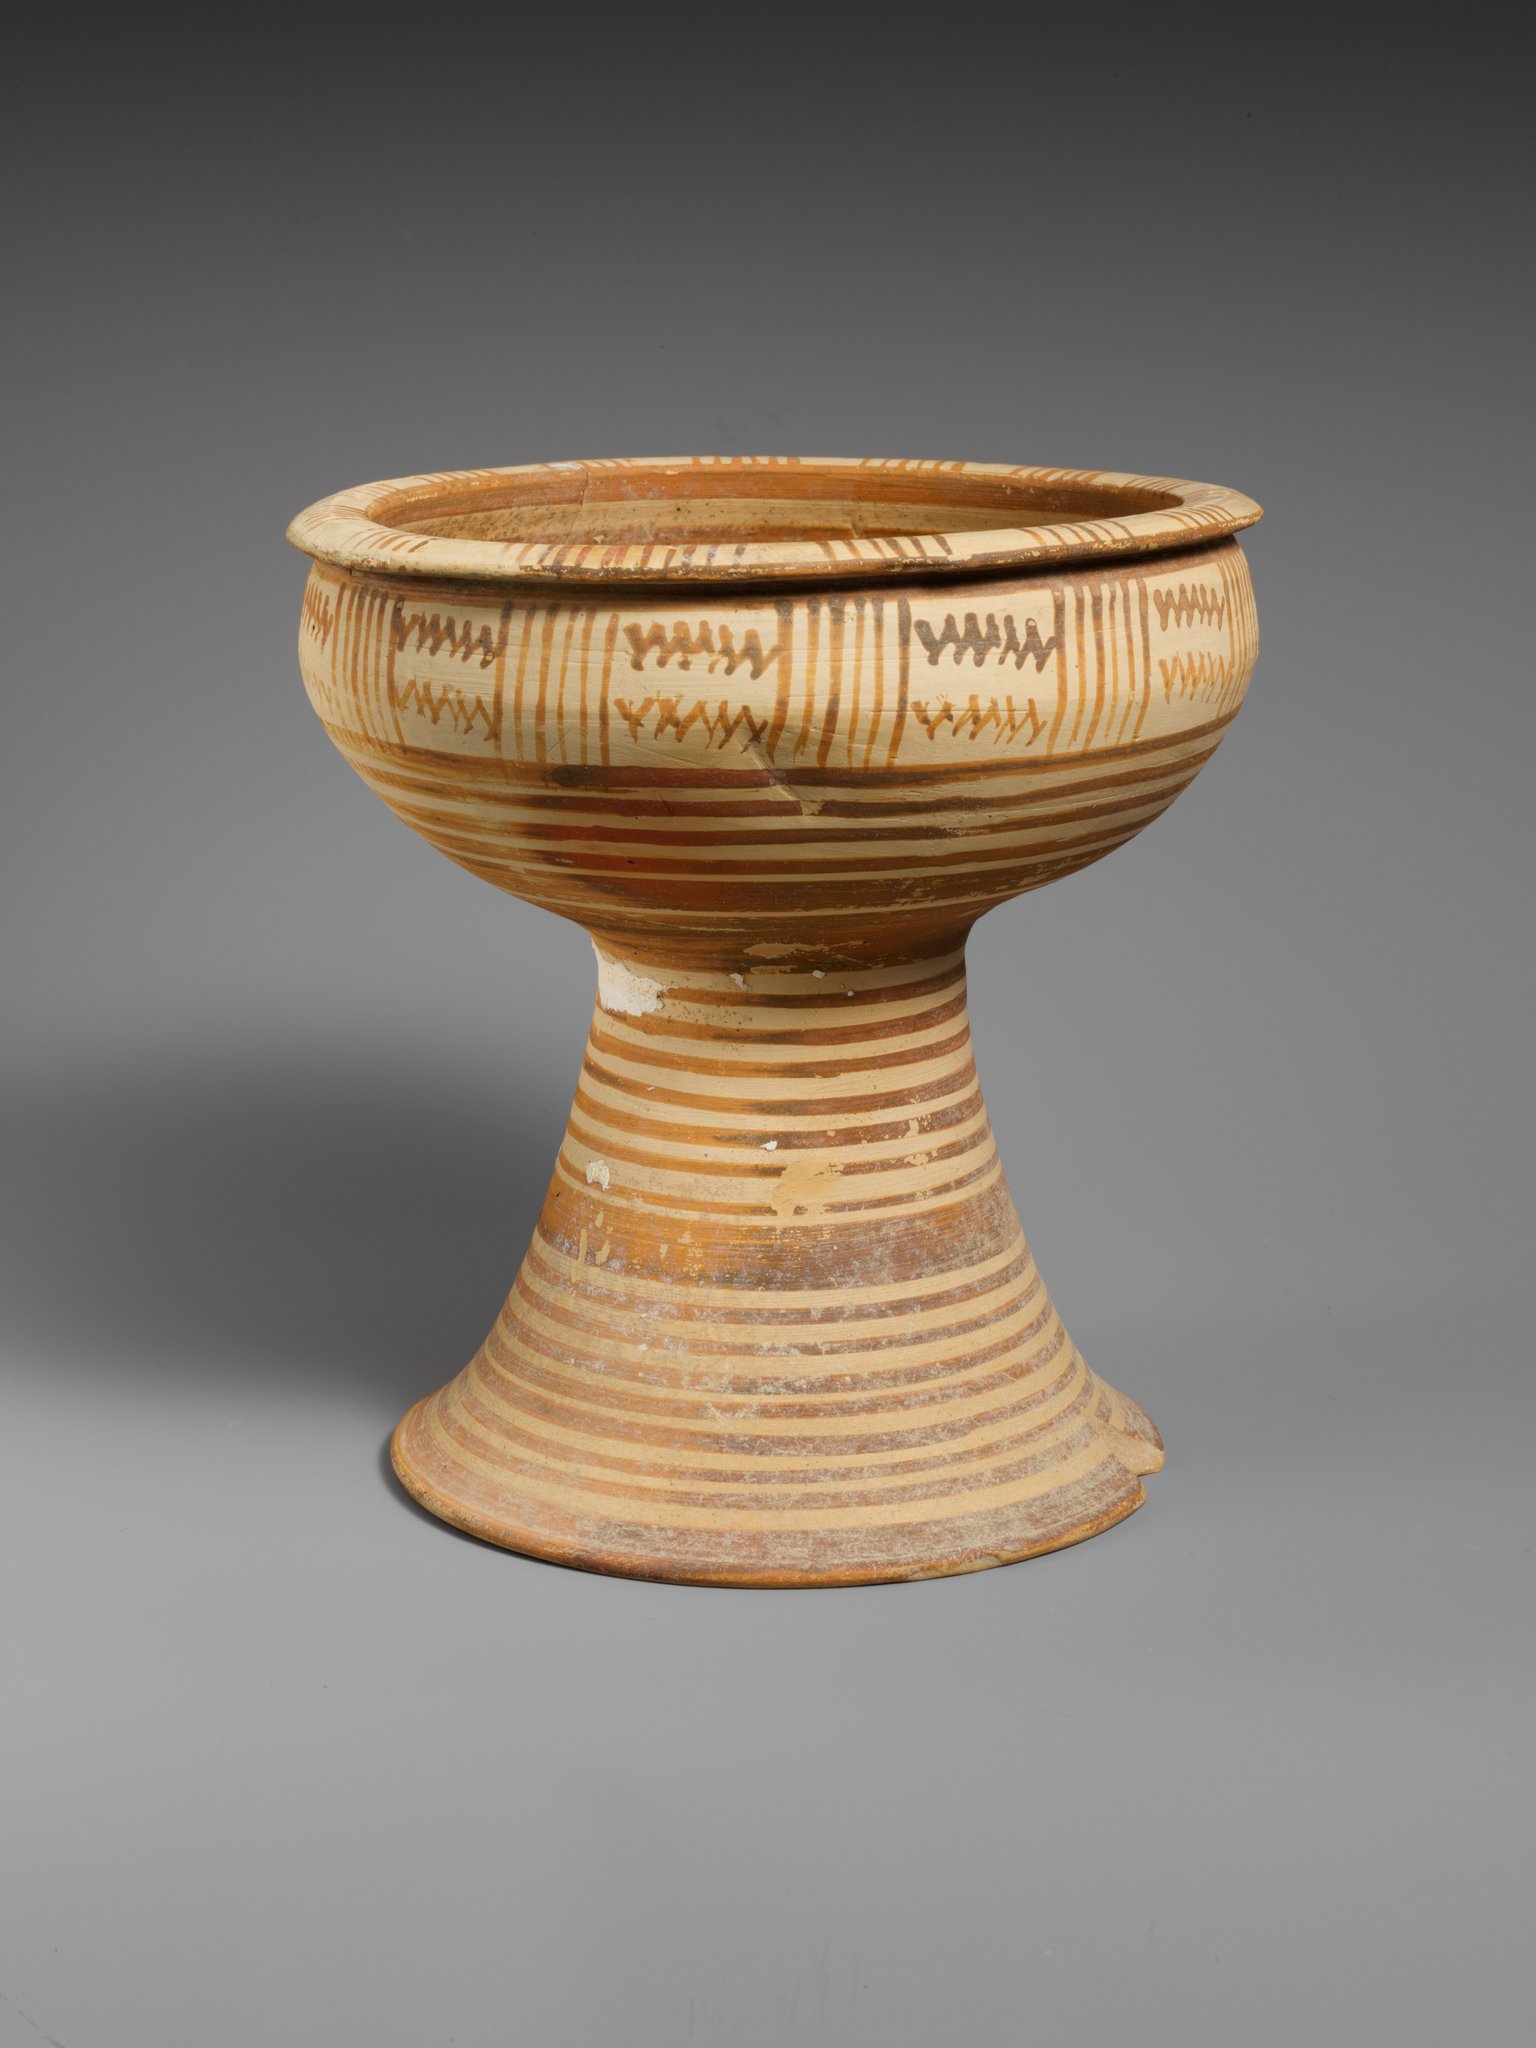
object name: bowl, stemmed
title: Terracotta footed bowl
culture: etruscan, italo-geometric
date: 650 BCE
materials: terracotta